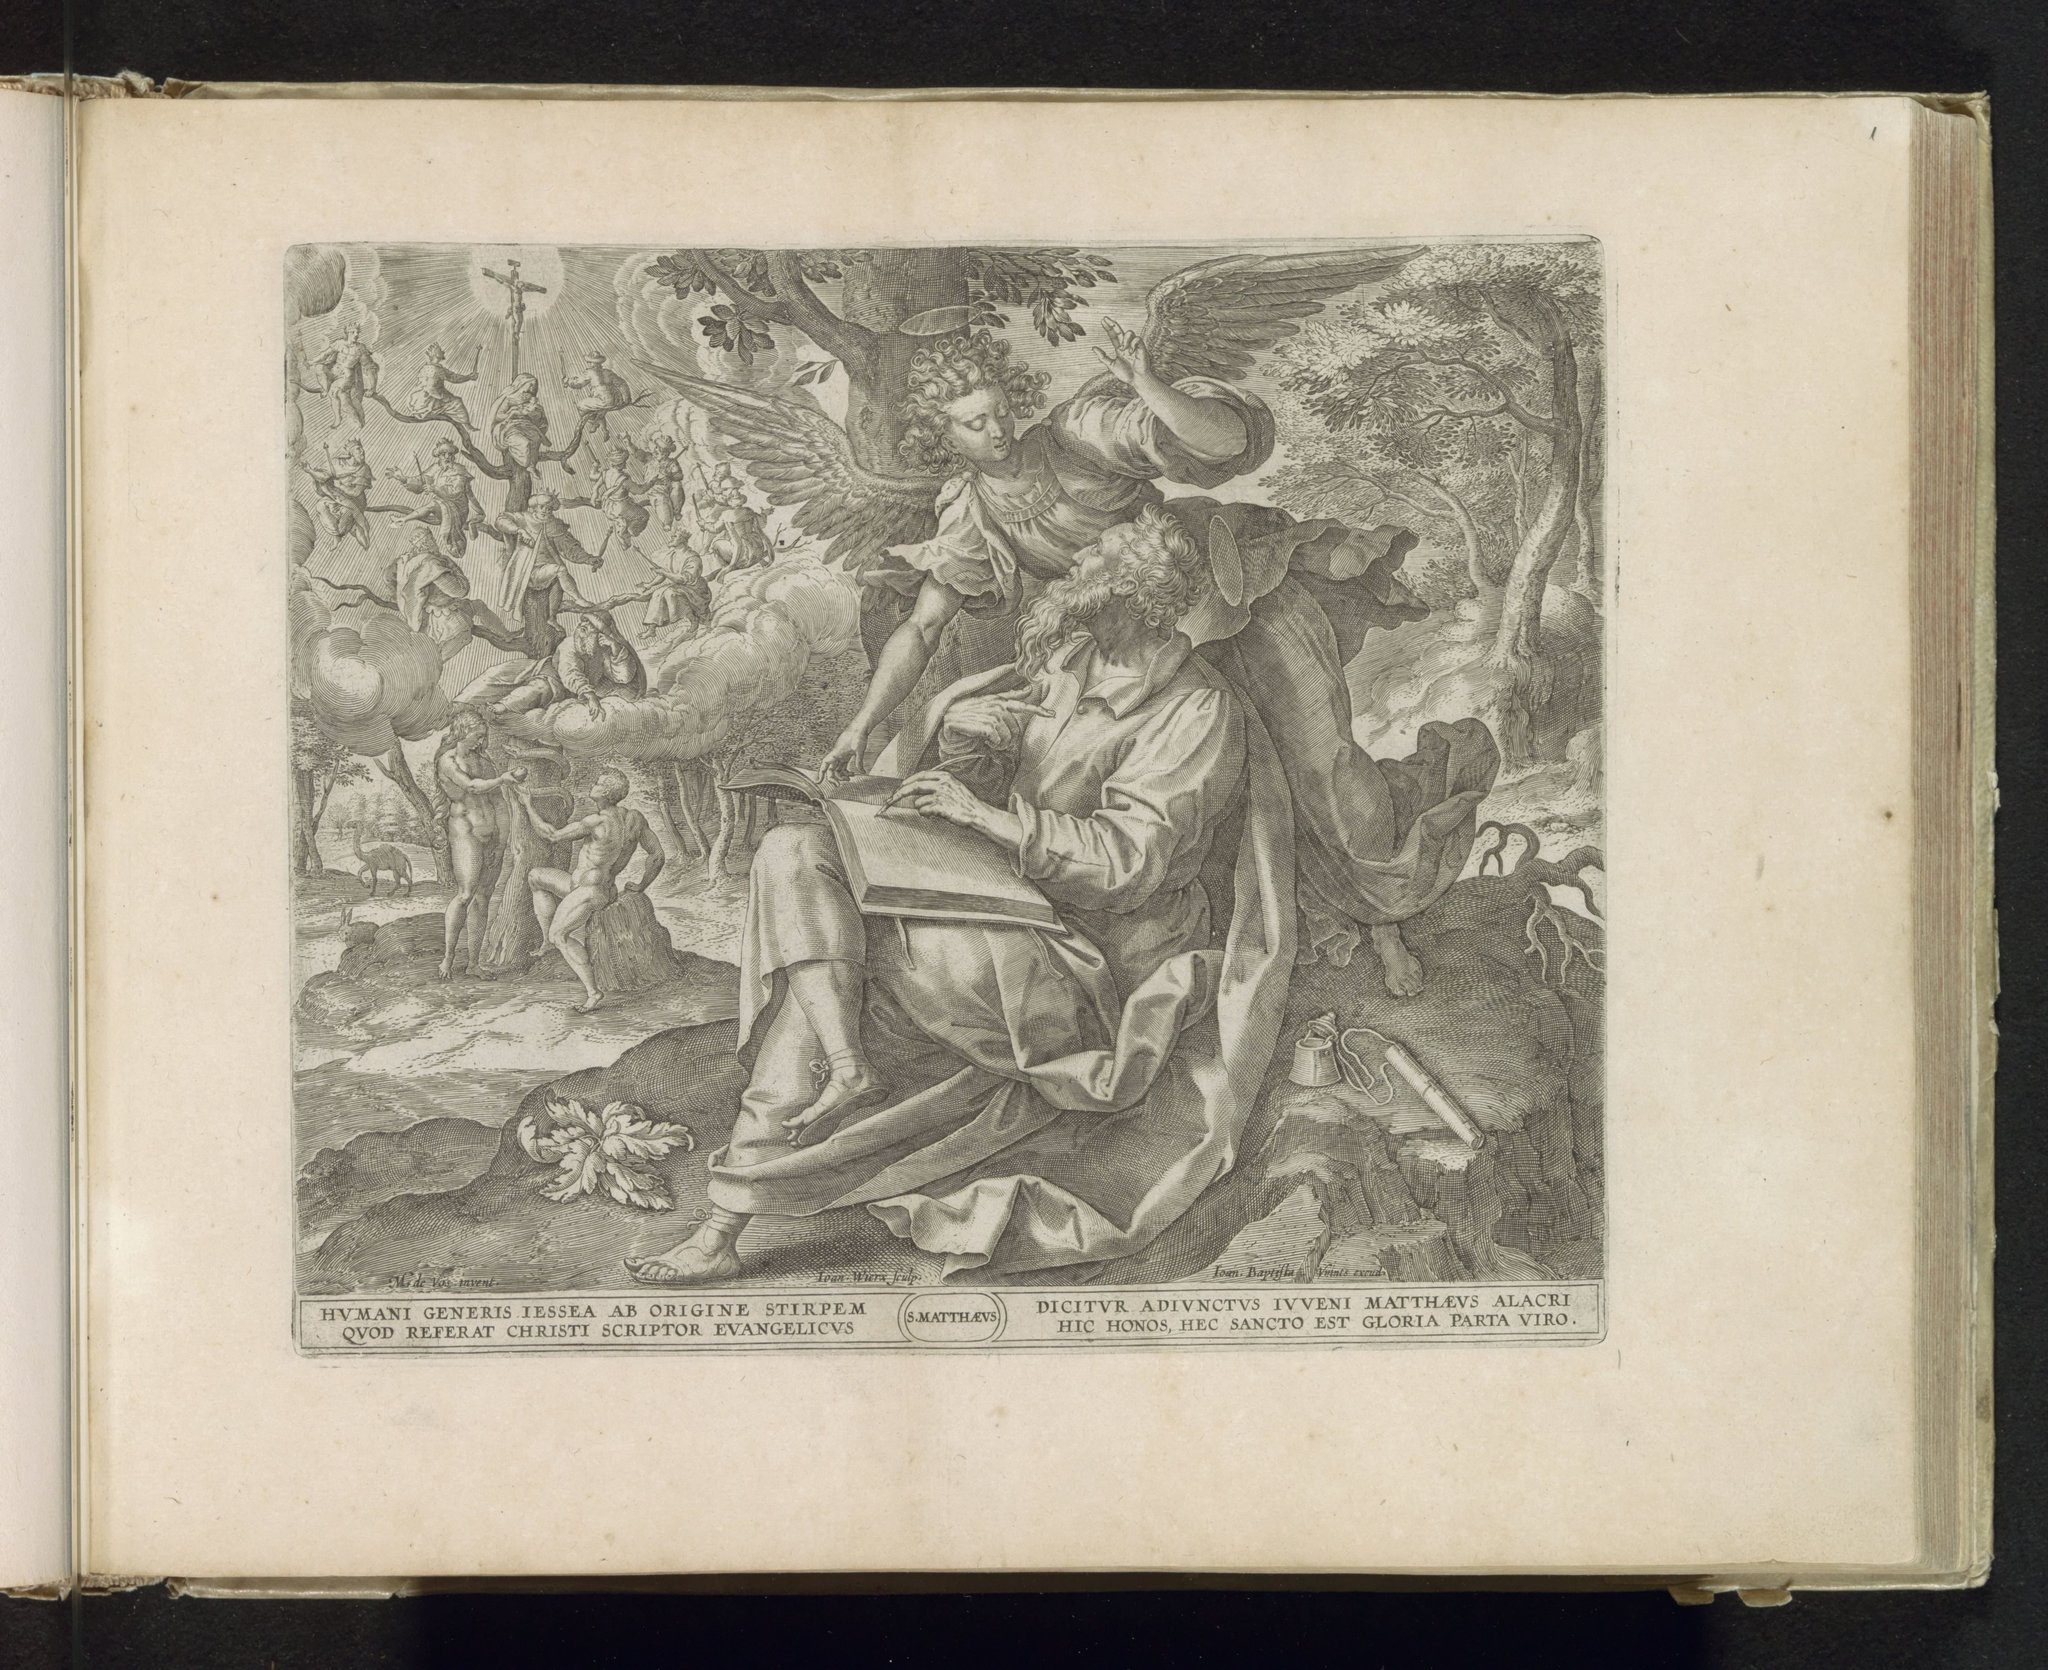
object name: print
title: Thesaurus novi Testamenti elegantissimis iconibus expressus continens historias atque miracula doni nostri Iesu Christi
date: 1585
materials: paper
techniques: engraving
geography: antwerp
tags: tree of jesse: genealogical tree showing christ's ancestors, sprouting from jesse's loins, st. matthew writing the gospel, usually the angel present, dictating or assisting him, temptation and fall (scenes with both adam and eve)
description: De evangelist Matteüs zit op de grond en schrijft zijn evangelie. Naast hem geeft een engel aanwijzingen. Linksachter de zondeval en de boom van Jesse. Bovenin de boom van Jesse zit Maria met Kind. De boom wordt bekroond door Christus aan het kruis. Onder de voorstelling een tweeregelige tekst in het Latijn. Deze prent maakt deel uit van een album.